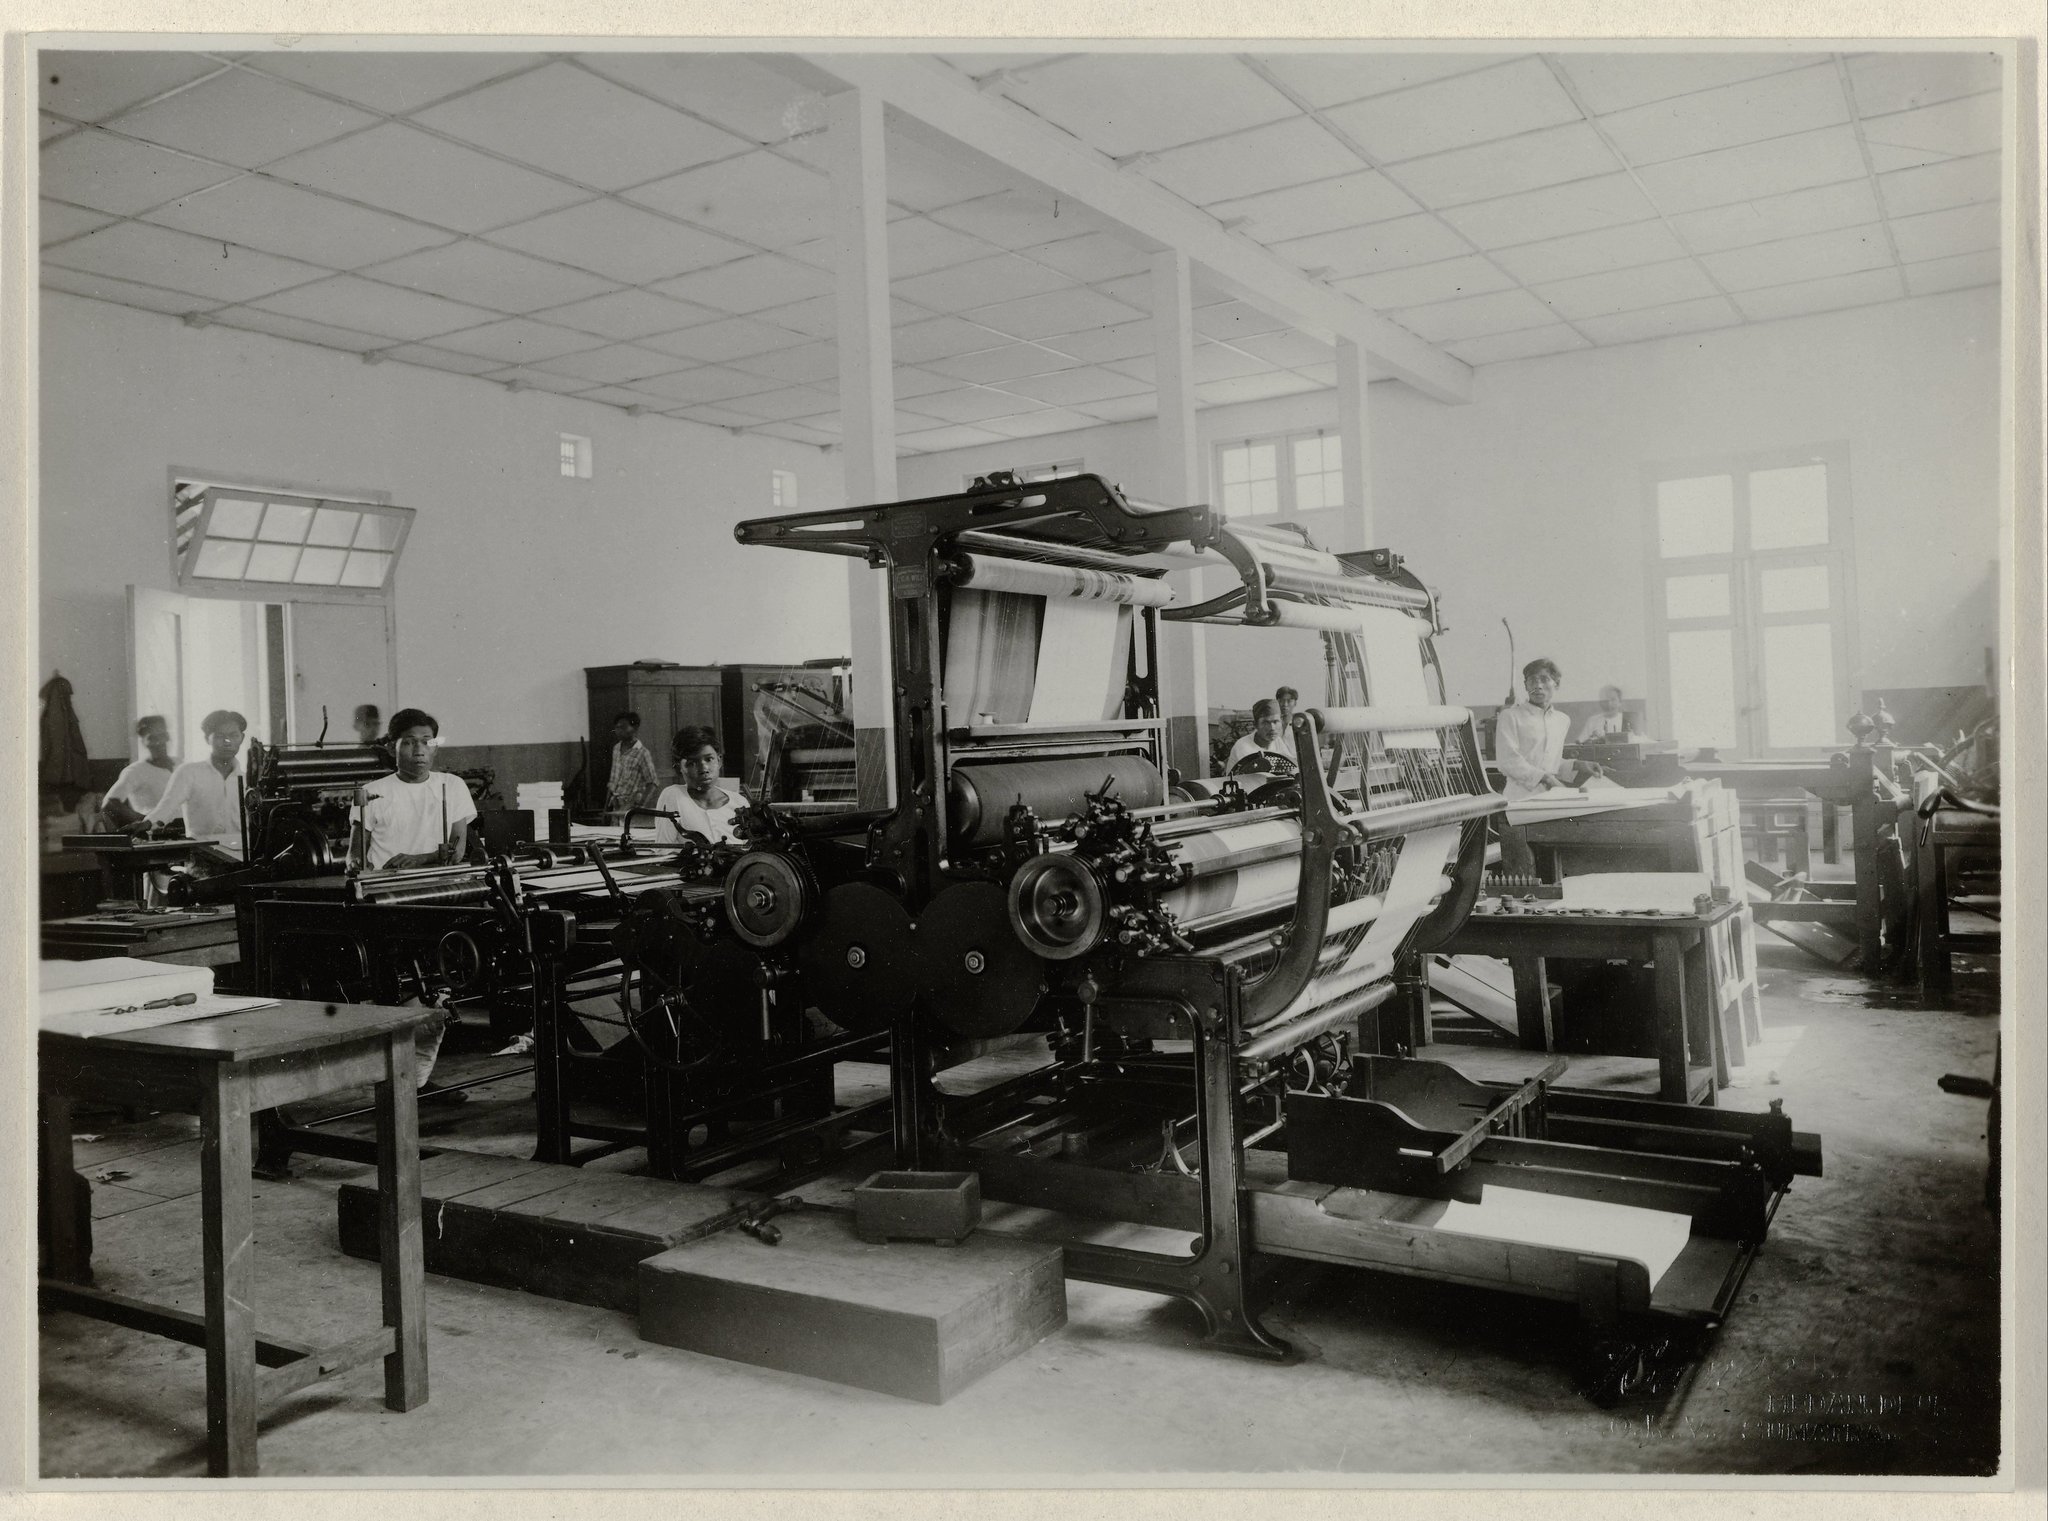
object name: photograph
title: Grote linieermachine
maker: t. kaneo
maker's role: fotograaf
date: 1921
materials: photographic support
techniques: gelatin silver print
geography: medan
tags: dutch east indies, the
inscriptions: inscription: ‘Groote linieermachine’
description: Een grote linieermachine in de drukkerij van de Deli Courant te Medan. Bij de machine staan Javaanse werknemers. Onderdeel van een groep van 18 foto's uit 1921 binnen de groep van 49 losse zwart-wit foto's van verschillend formaat over de uitgeverij en drukkerij van de krant Deli Courant in Medan in de periode 1885-1947.